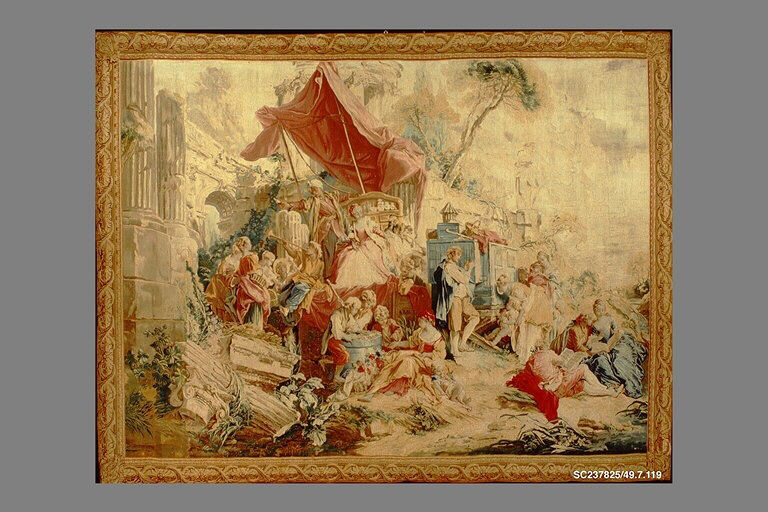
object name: tapestry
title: The Charlatan and the Peep Show from a set of Italian Village Scenes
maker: françois boucher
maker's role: artist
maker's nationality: french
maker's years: 1703-1770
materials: silk, wool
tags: musical instruments,children,men,women,monkeys